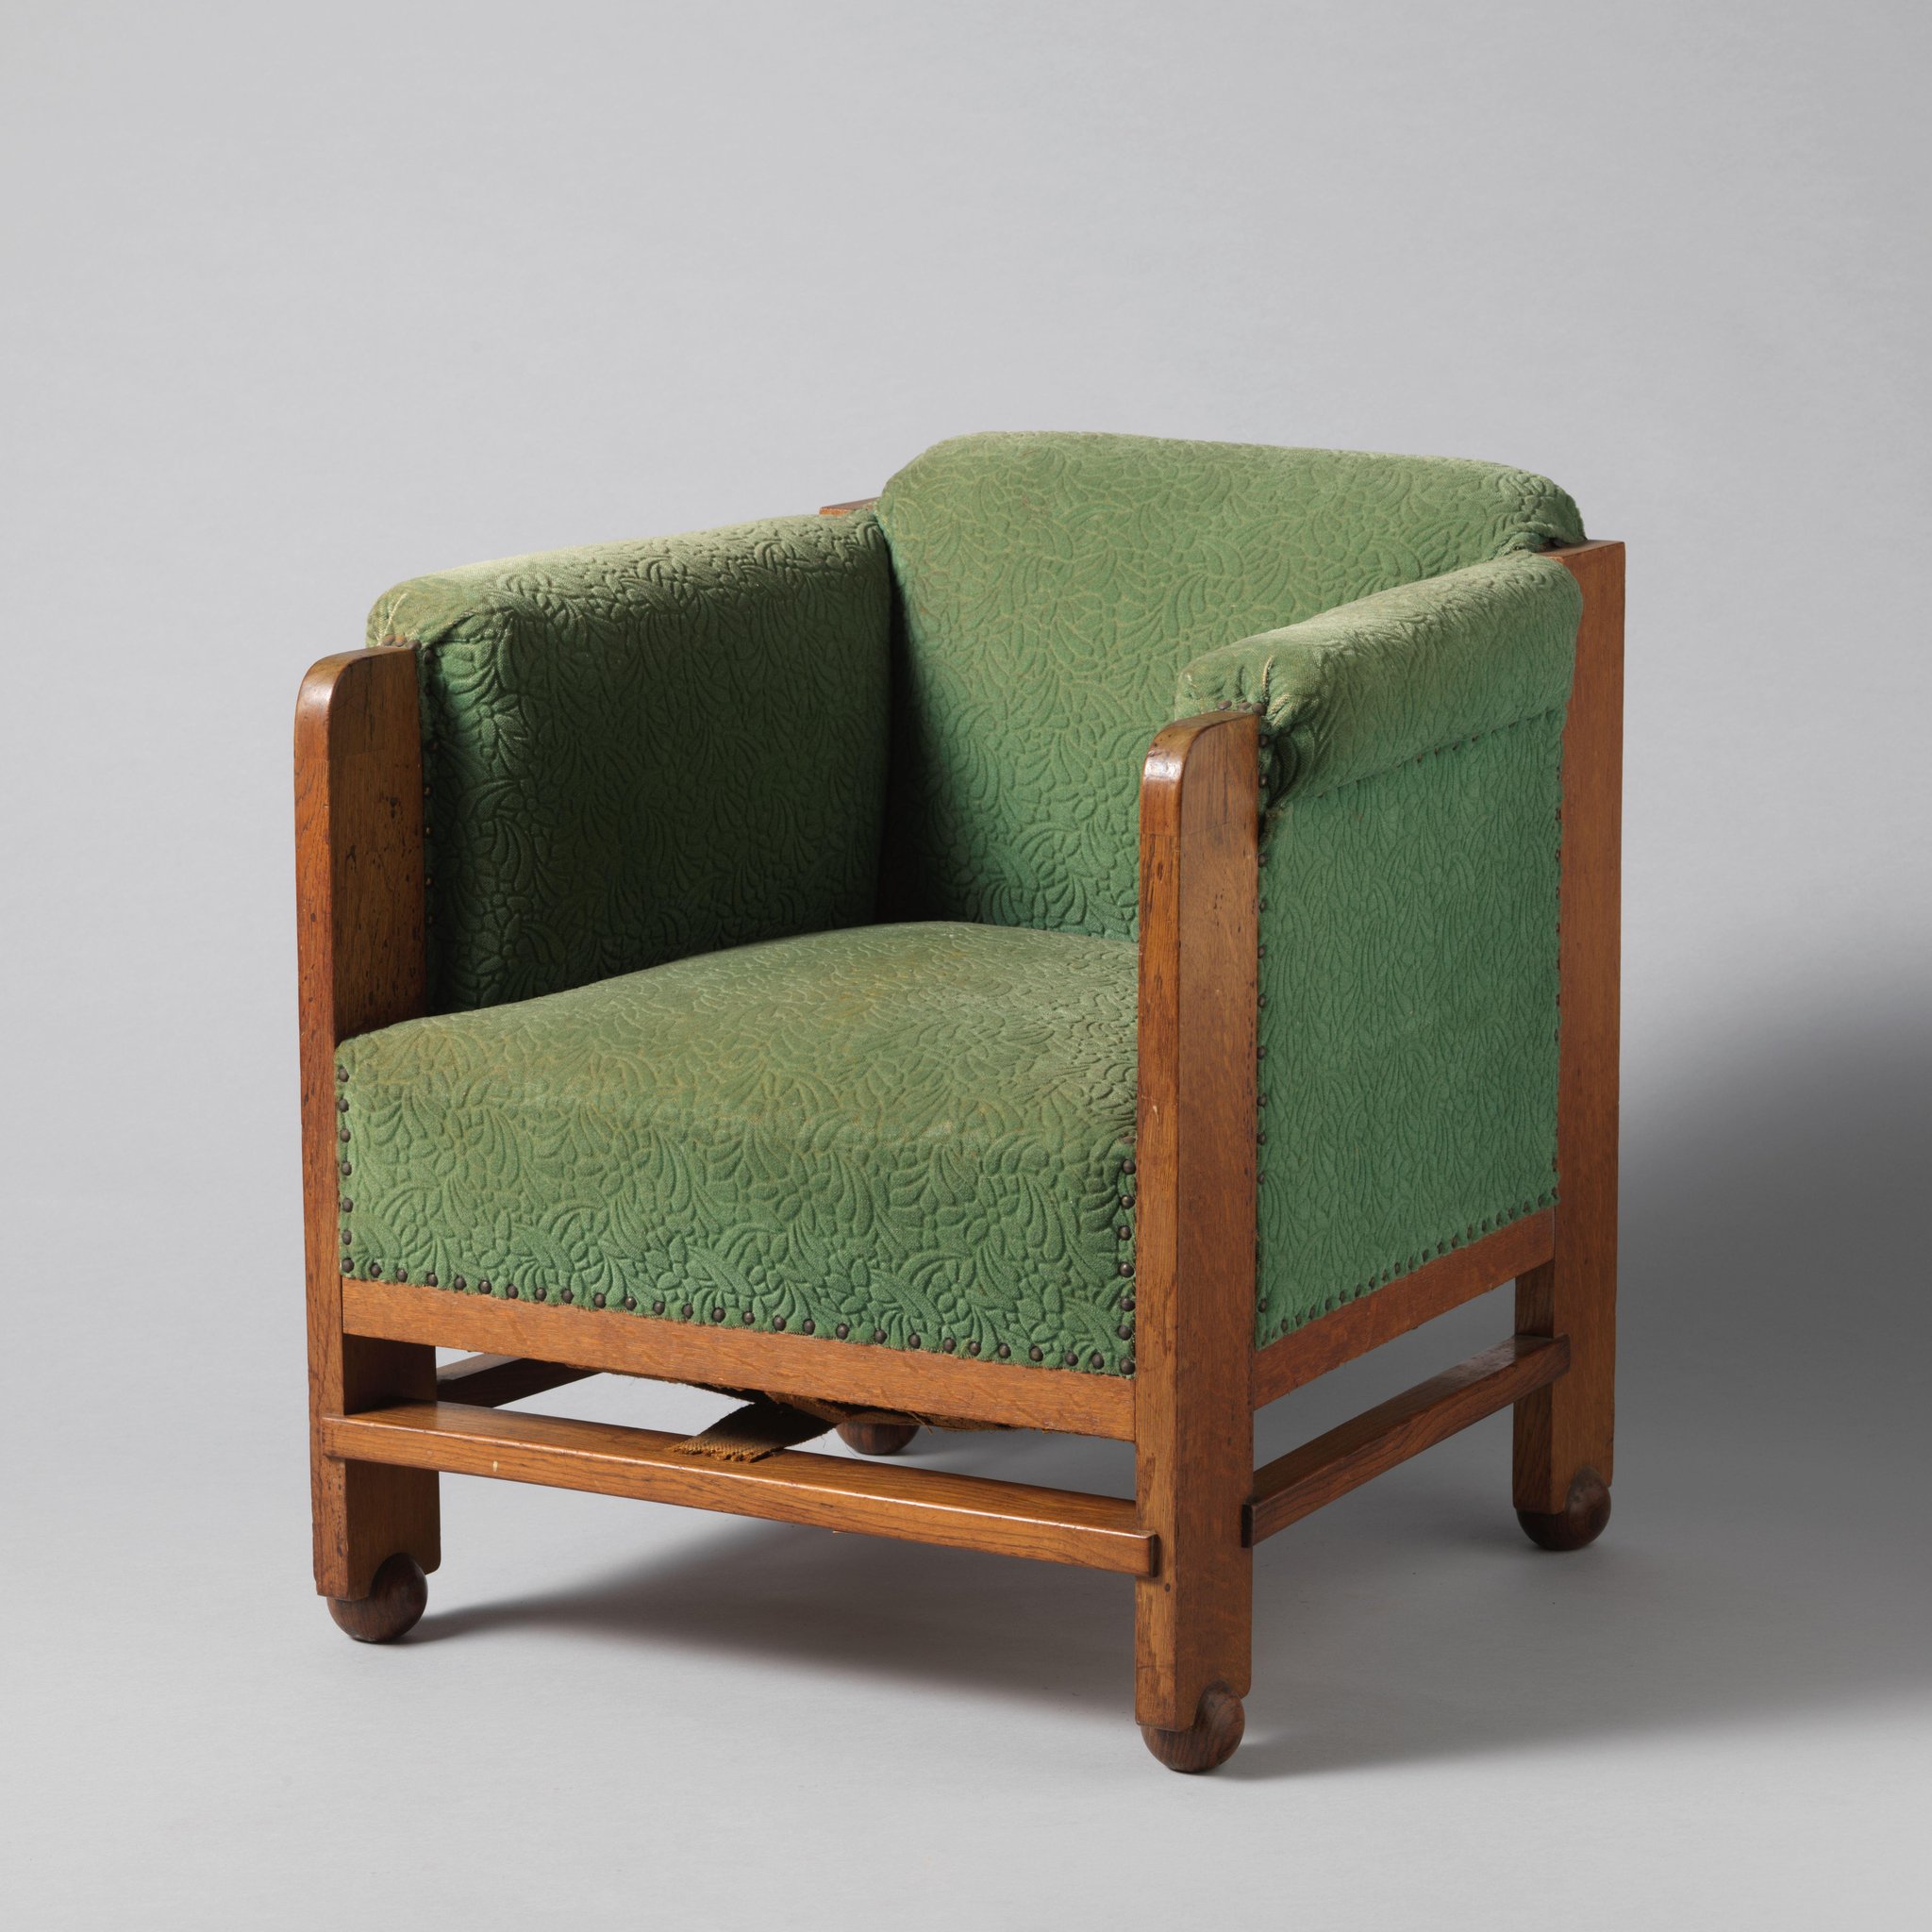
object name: chair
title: Fauteuil voor een dame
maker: ernst schubad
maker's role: interieurontwerper, meubelontwerper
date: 1910-1927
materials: wood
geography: netherlands